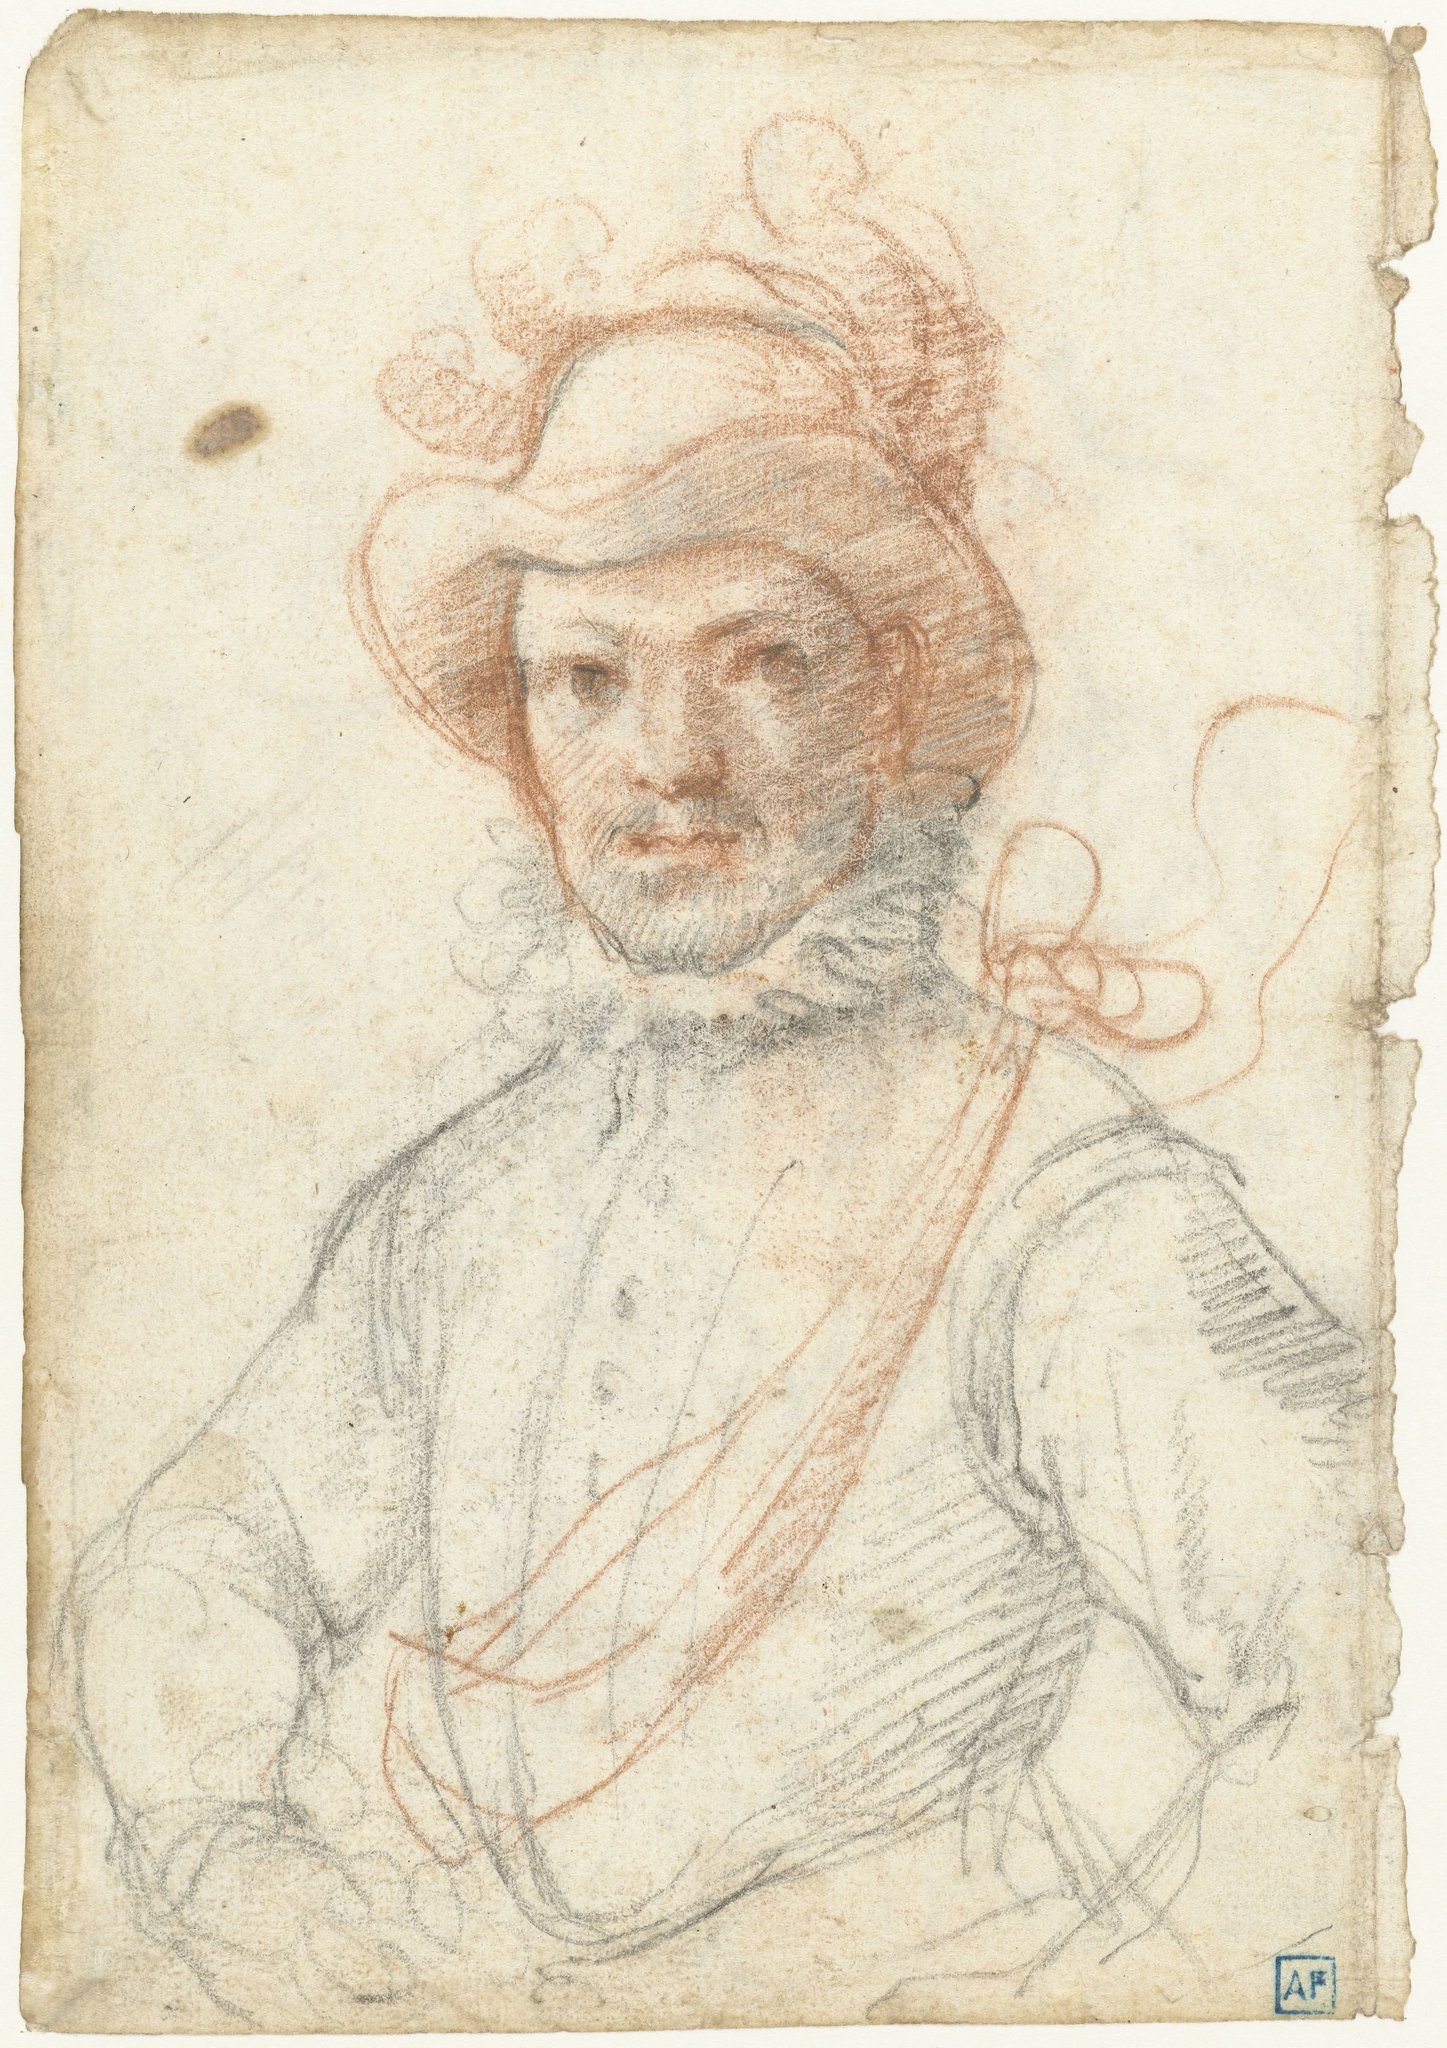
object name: drawing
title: Portret van een krijgsman, met gepluimde hoed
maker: federico zuccaro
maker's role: draughtsman, print maker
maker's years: 1540-1609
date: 1550-1609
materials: chalk, paper